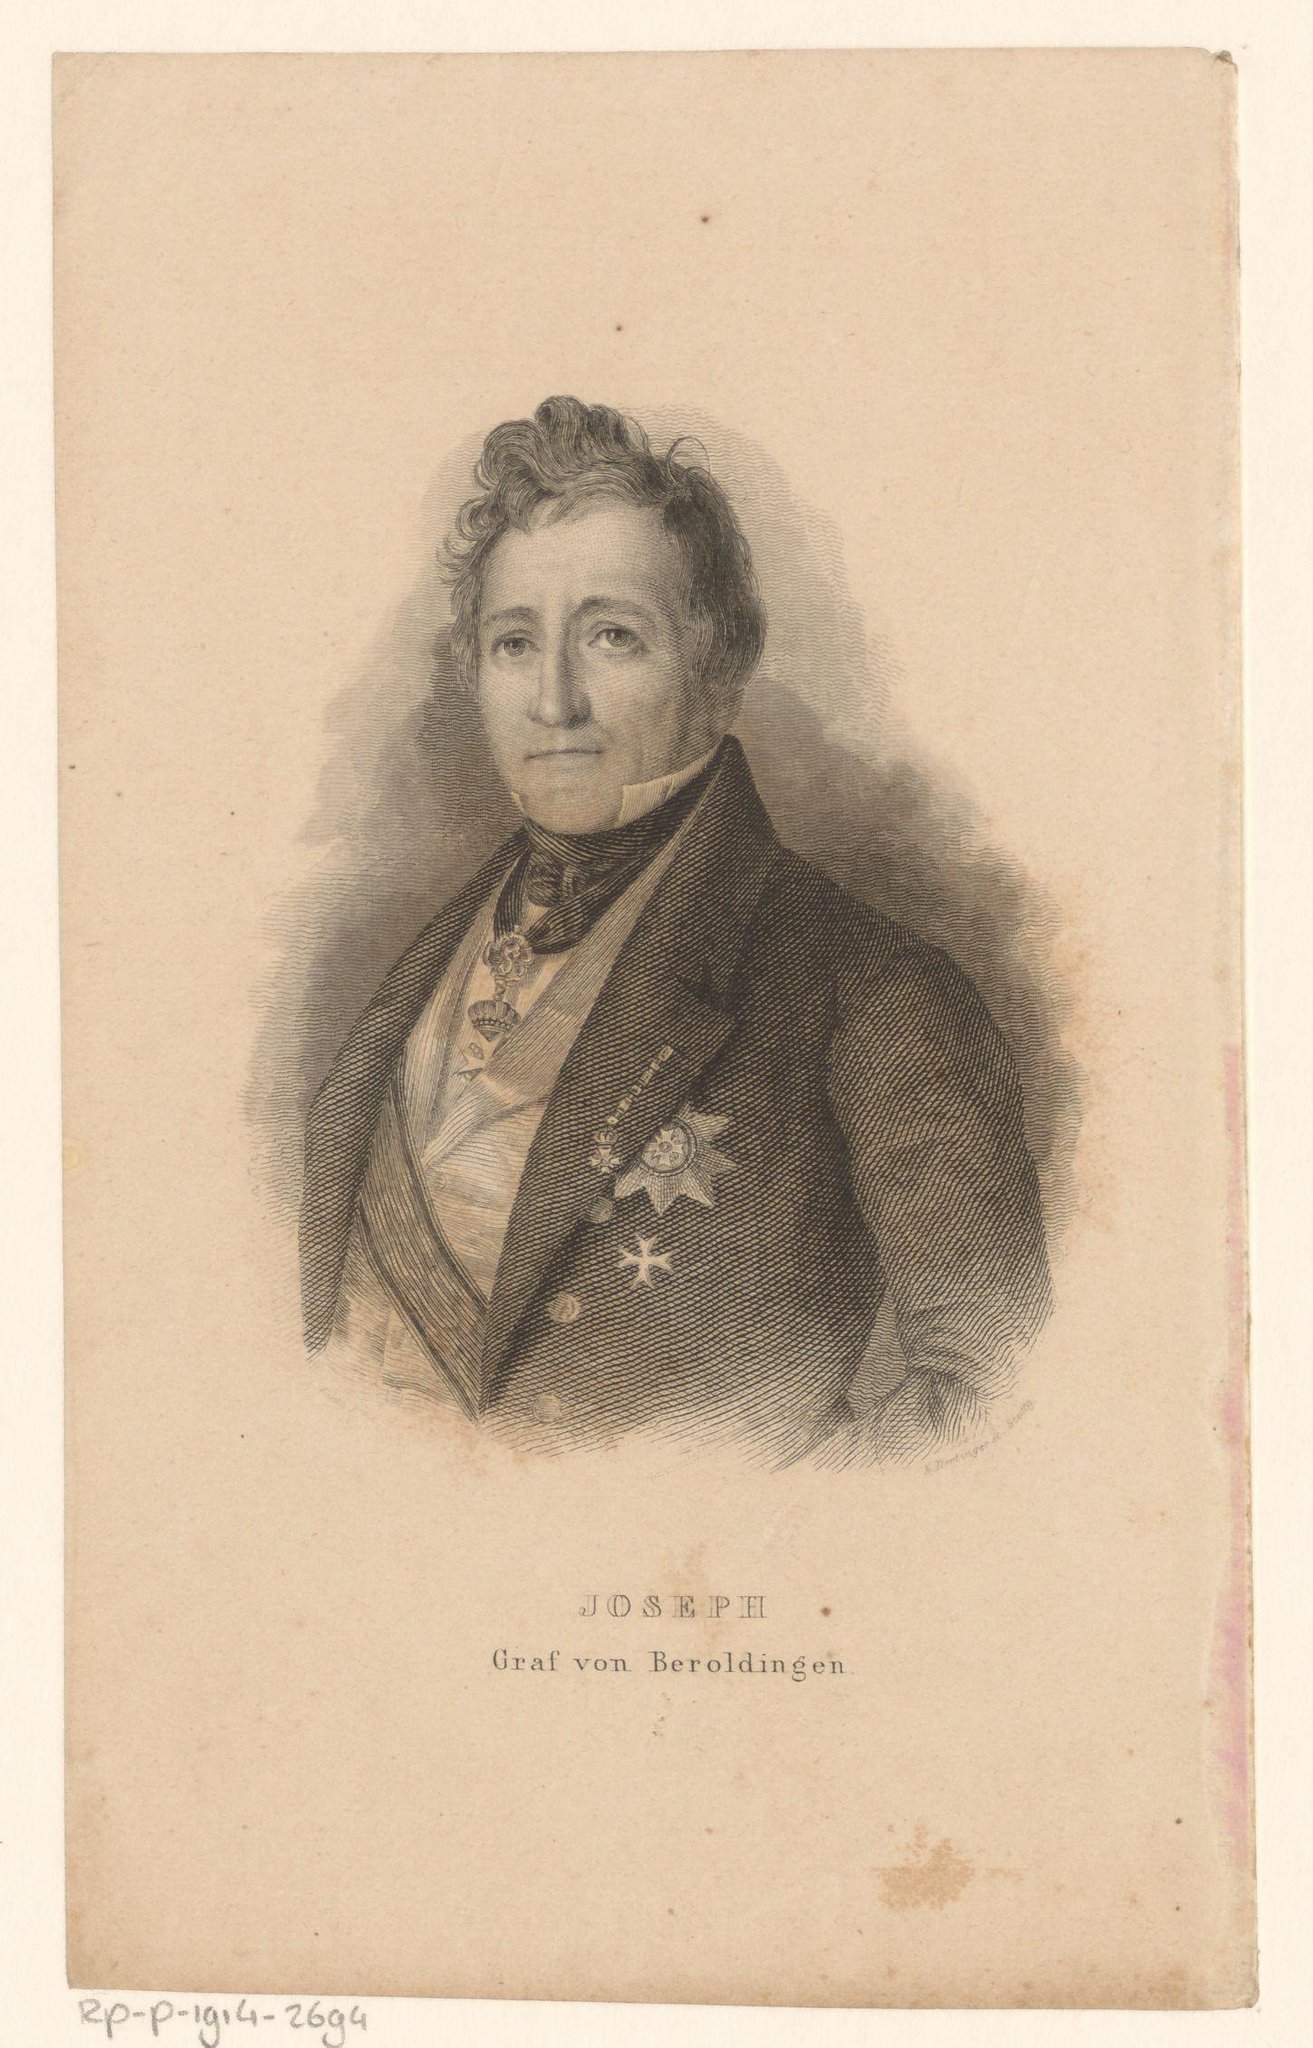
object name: print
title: Joseph Graf von Beroldingen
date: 1826-1865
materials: paper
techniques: engraving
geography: stuttgart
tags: knighthood order: teutonic order - insignia of a knighthood order, e.g.: badge, chain (with name of order), knighthood order, historical persons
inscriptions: collector's mark: Lugt 2228